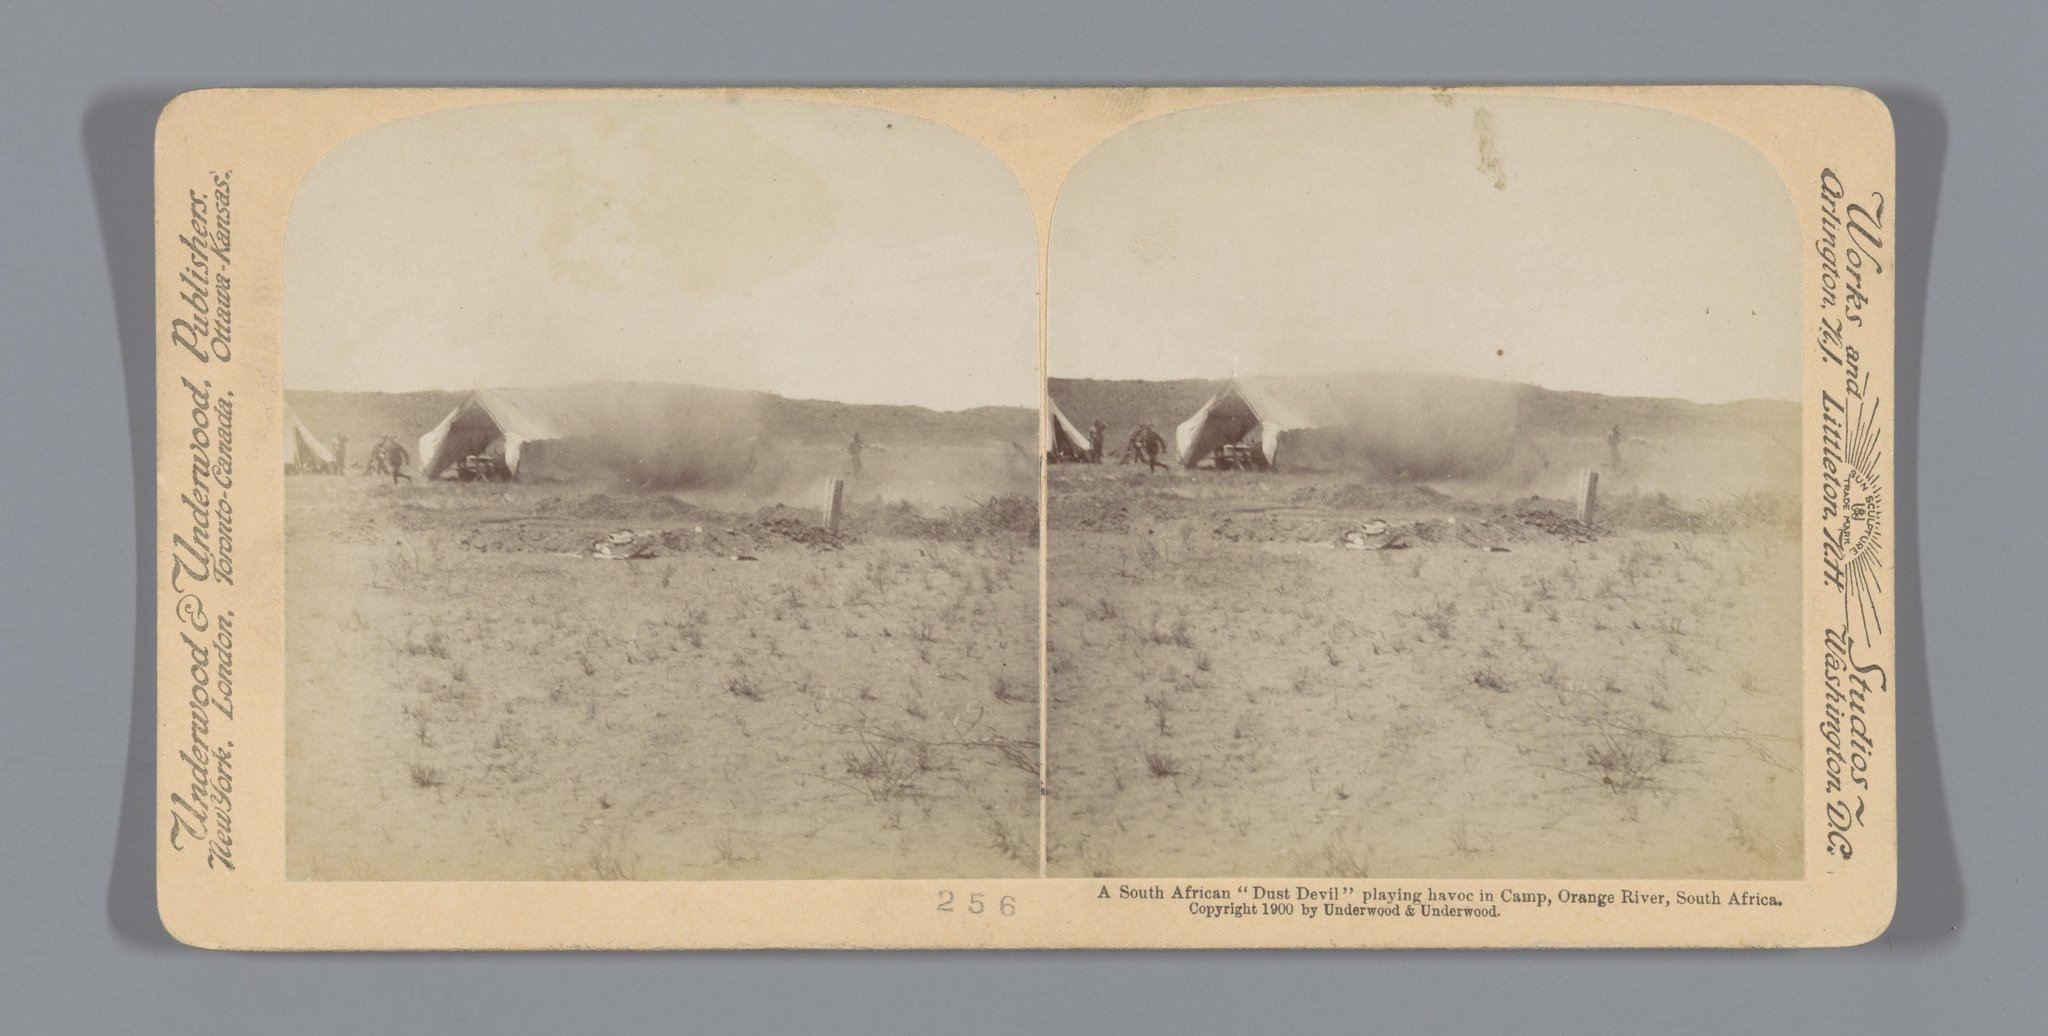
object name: stereograph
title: Wervelwind zorgt voor chaos in een Brits legerkamp nabij de Oranjerivier, Zuid-Afrika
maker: Anonymous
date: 1900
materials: cardboard, paper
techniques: albumen print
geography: orange river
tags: (military) camp with tents, whirlwind, cyclone, hurricane, typhoon, tornado on land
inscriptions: number: ‘256’, copyright notice: ‘Copyright 1900 Underwood & Underwood.’, inscription: ‘Works and Studios ~/ Arlington, N.J. Littleton, N.H. Washington, D.C.’, inscription